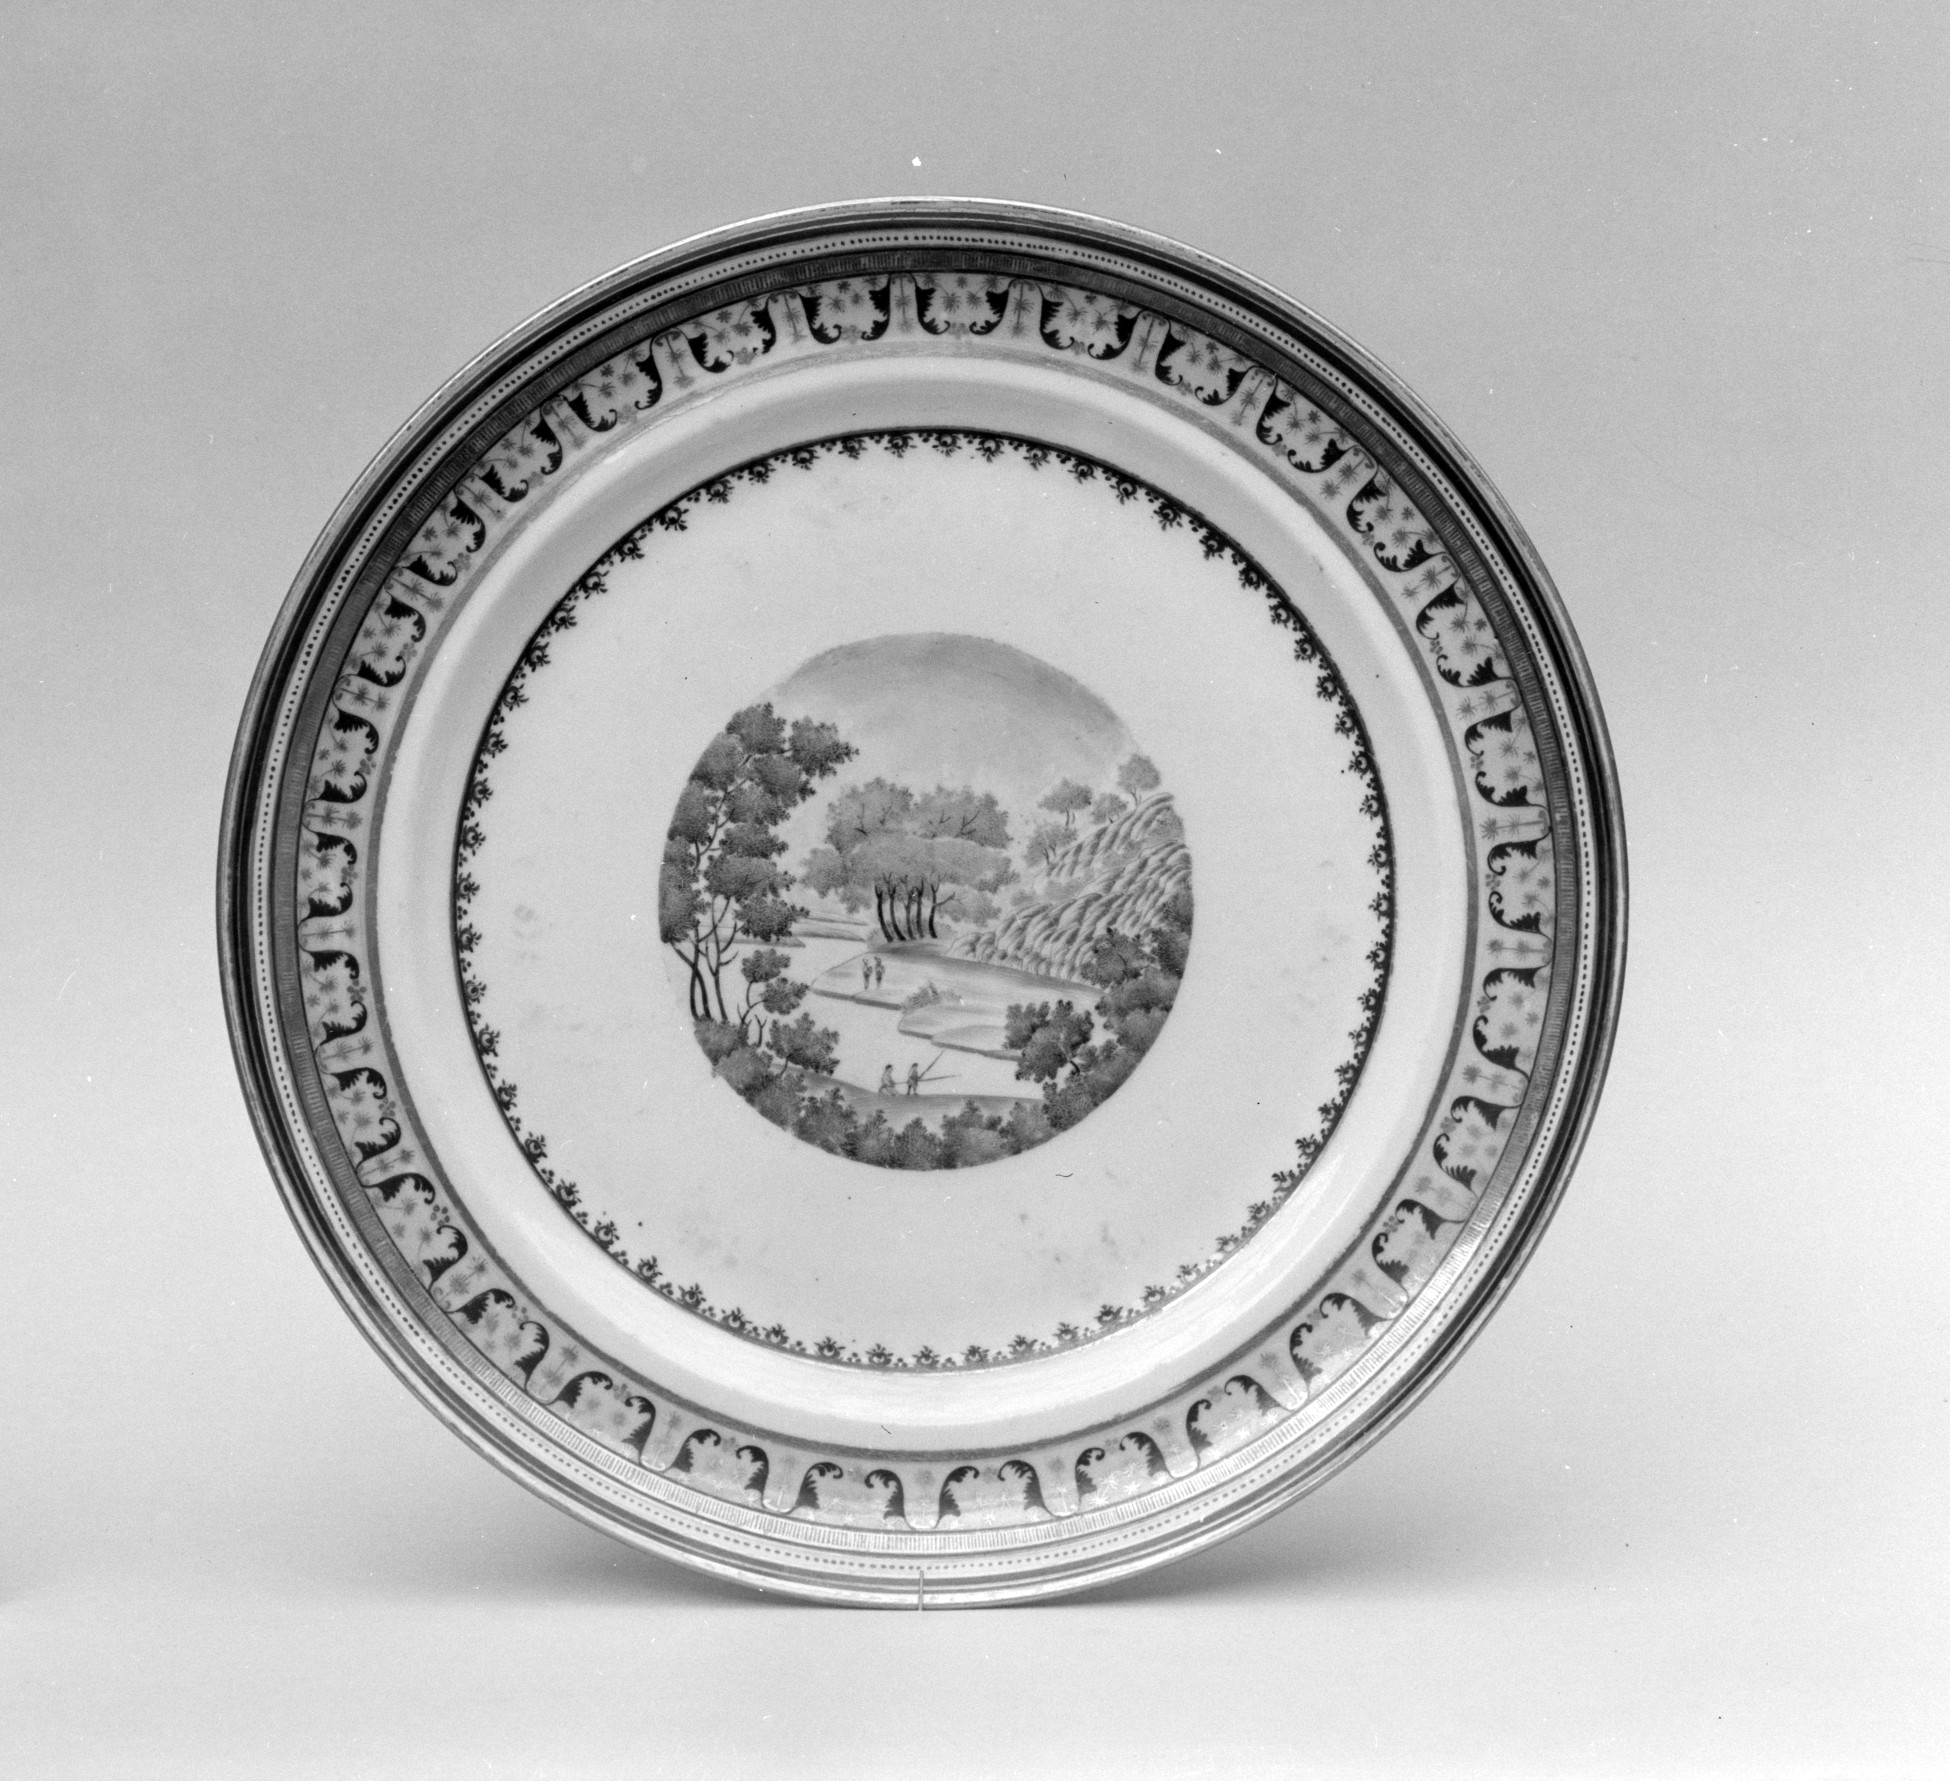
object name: plate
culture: chinese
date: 1800-1830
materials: porcelain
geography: china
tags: landscapes